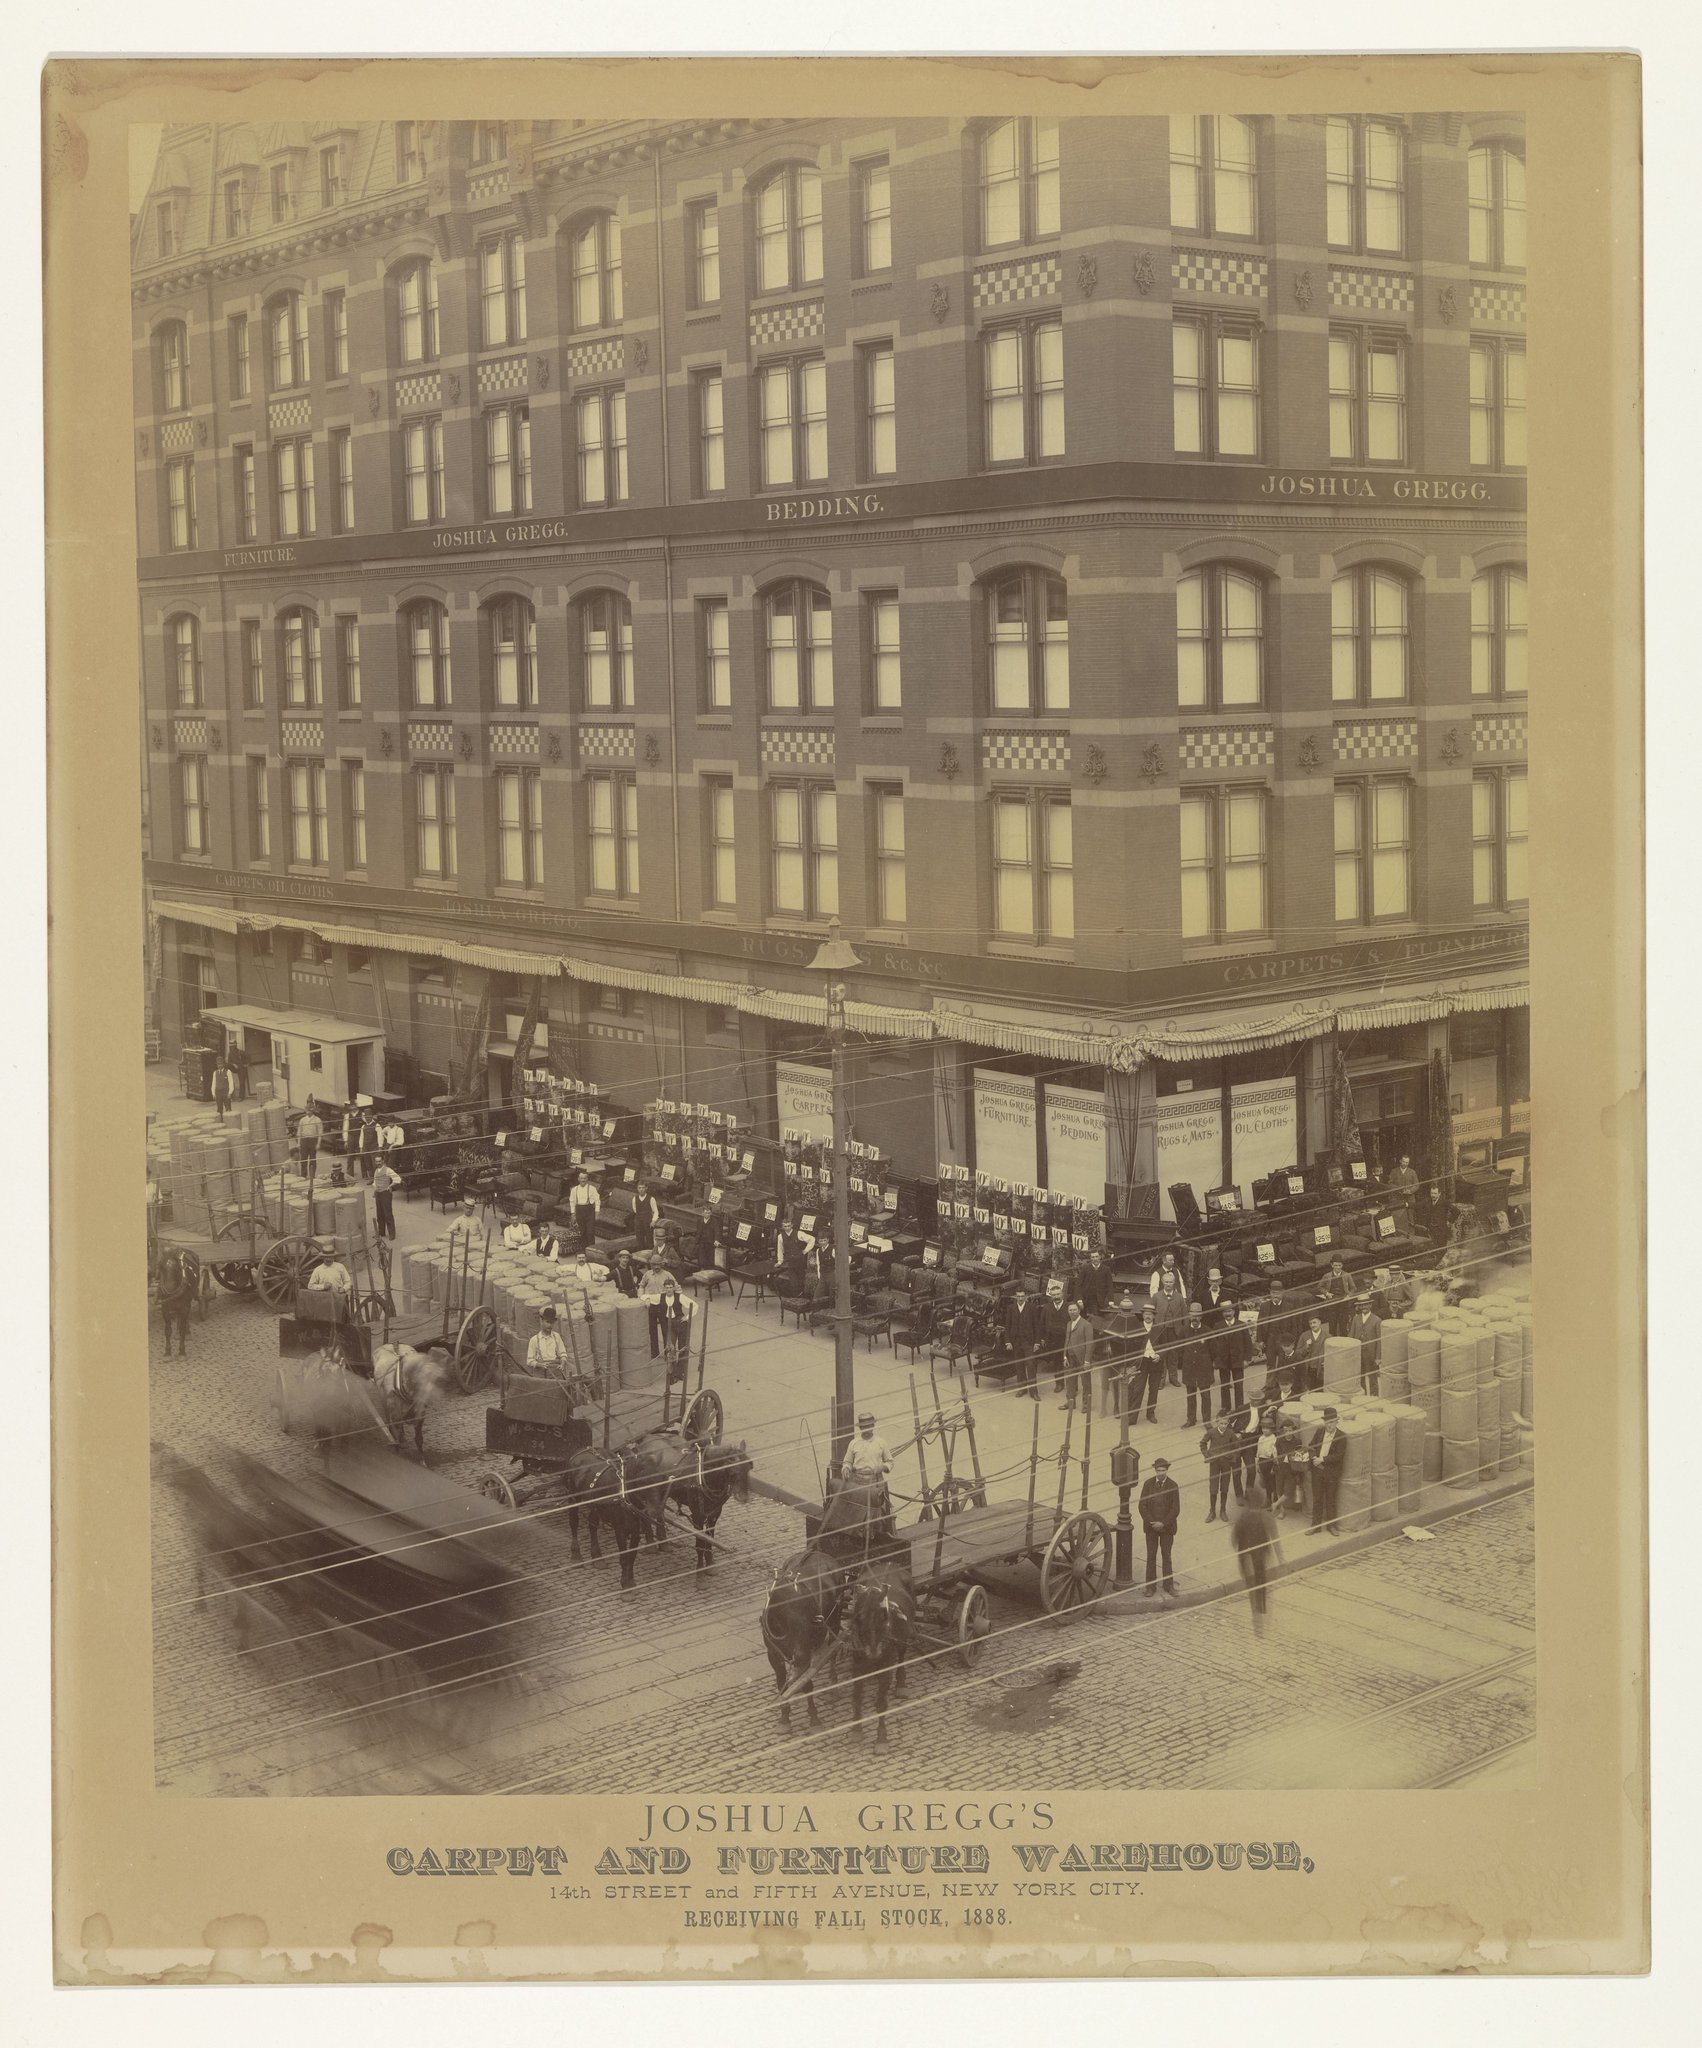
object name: photograph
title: Reclamefoto voor Joshua Gregg's Carpet and Furniture Warehouse, New York City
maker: Anonymous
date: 1888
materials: cardboard, paper, photographic support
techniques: albumen print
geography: united states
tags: new york (city)